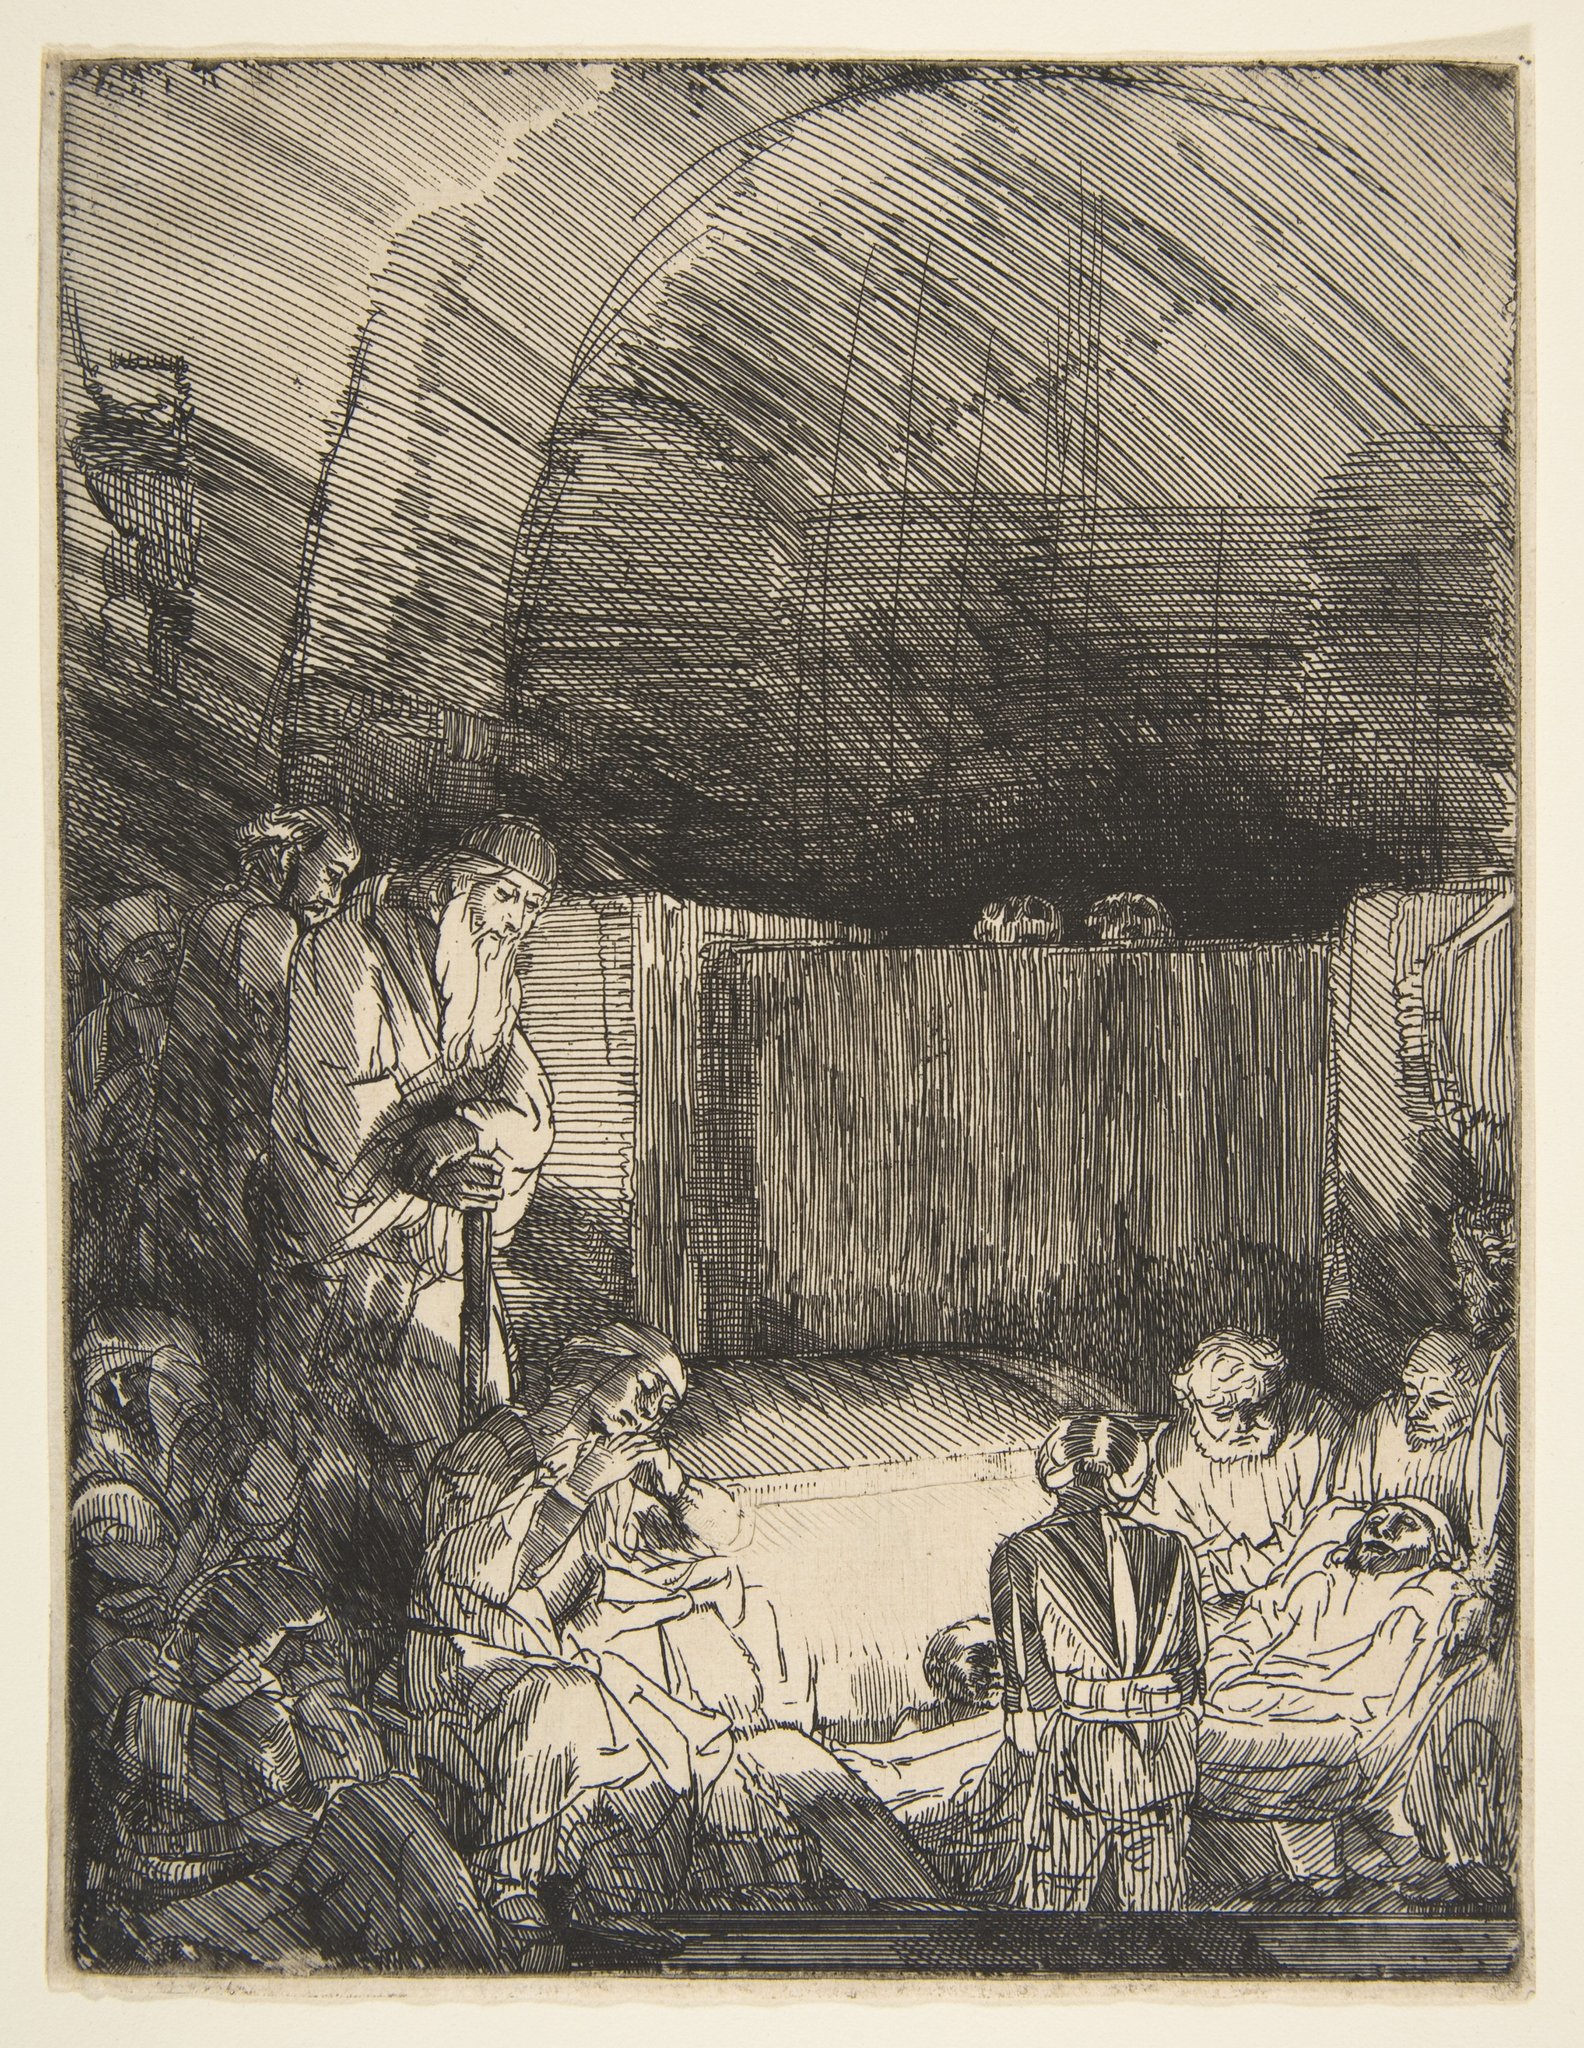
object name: print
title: The Entombment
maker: rembrandt van rijn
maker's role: artist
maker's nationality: dutch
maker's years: 1606-1669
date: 1654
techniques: drypoint, etching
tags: men,christ,entombment